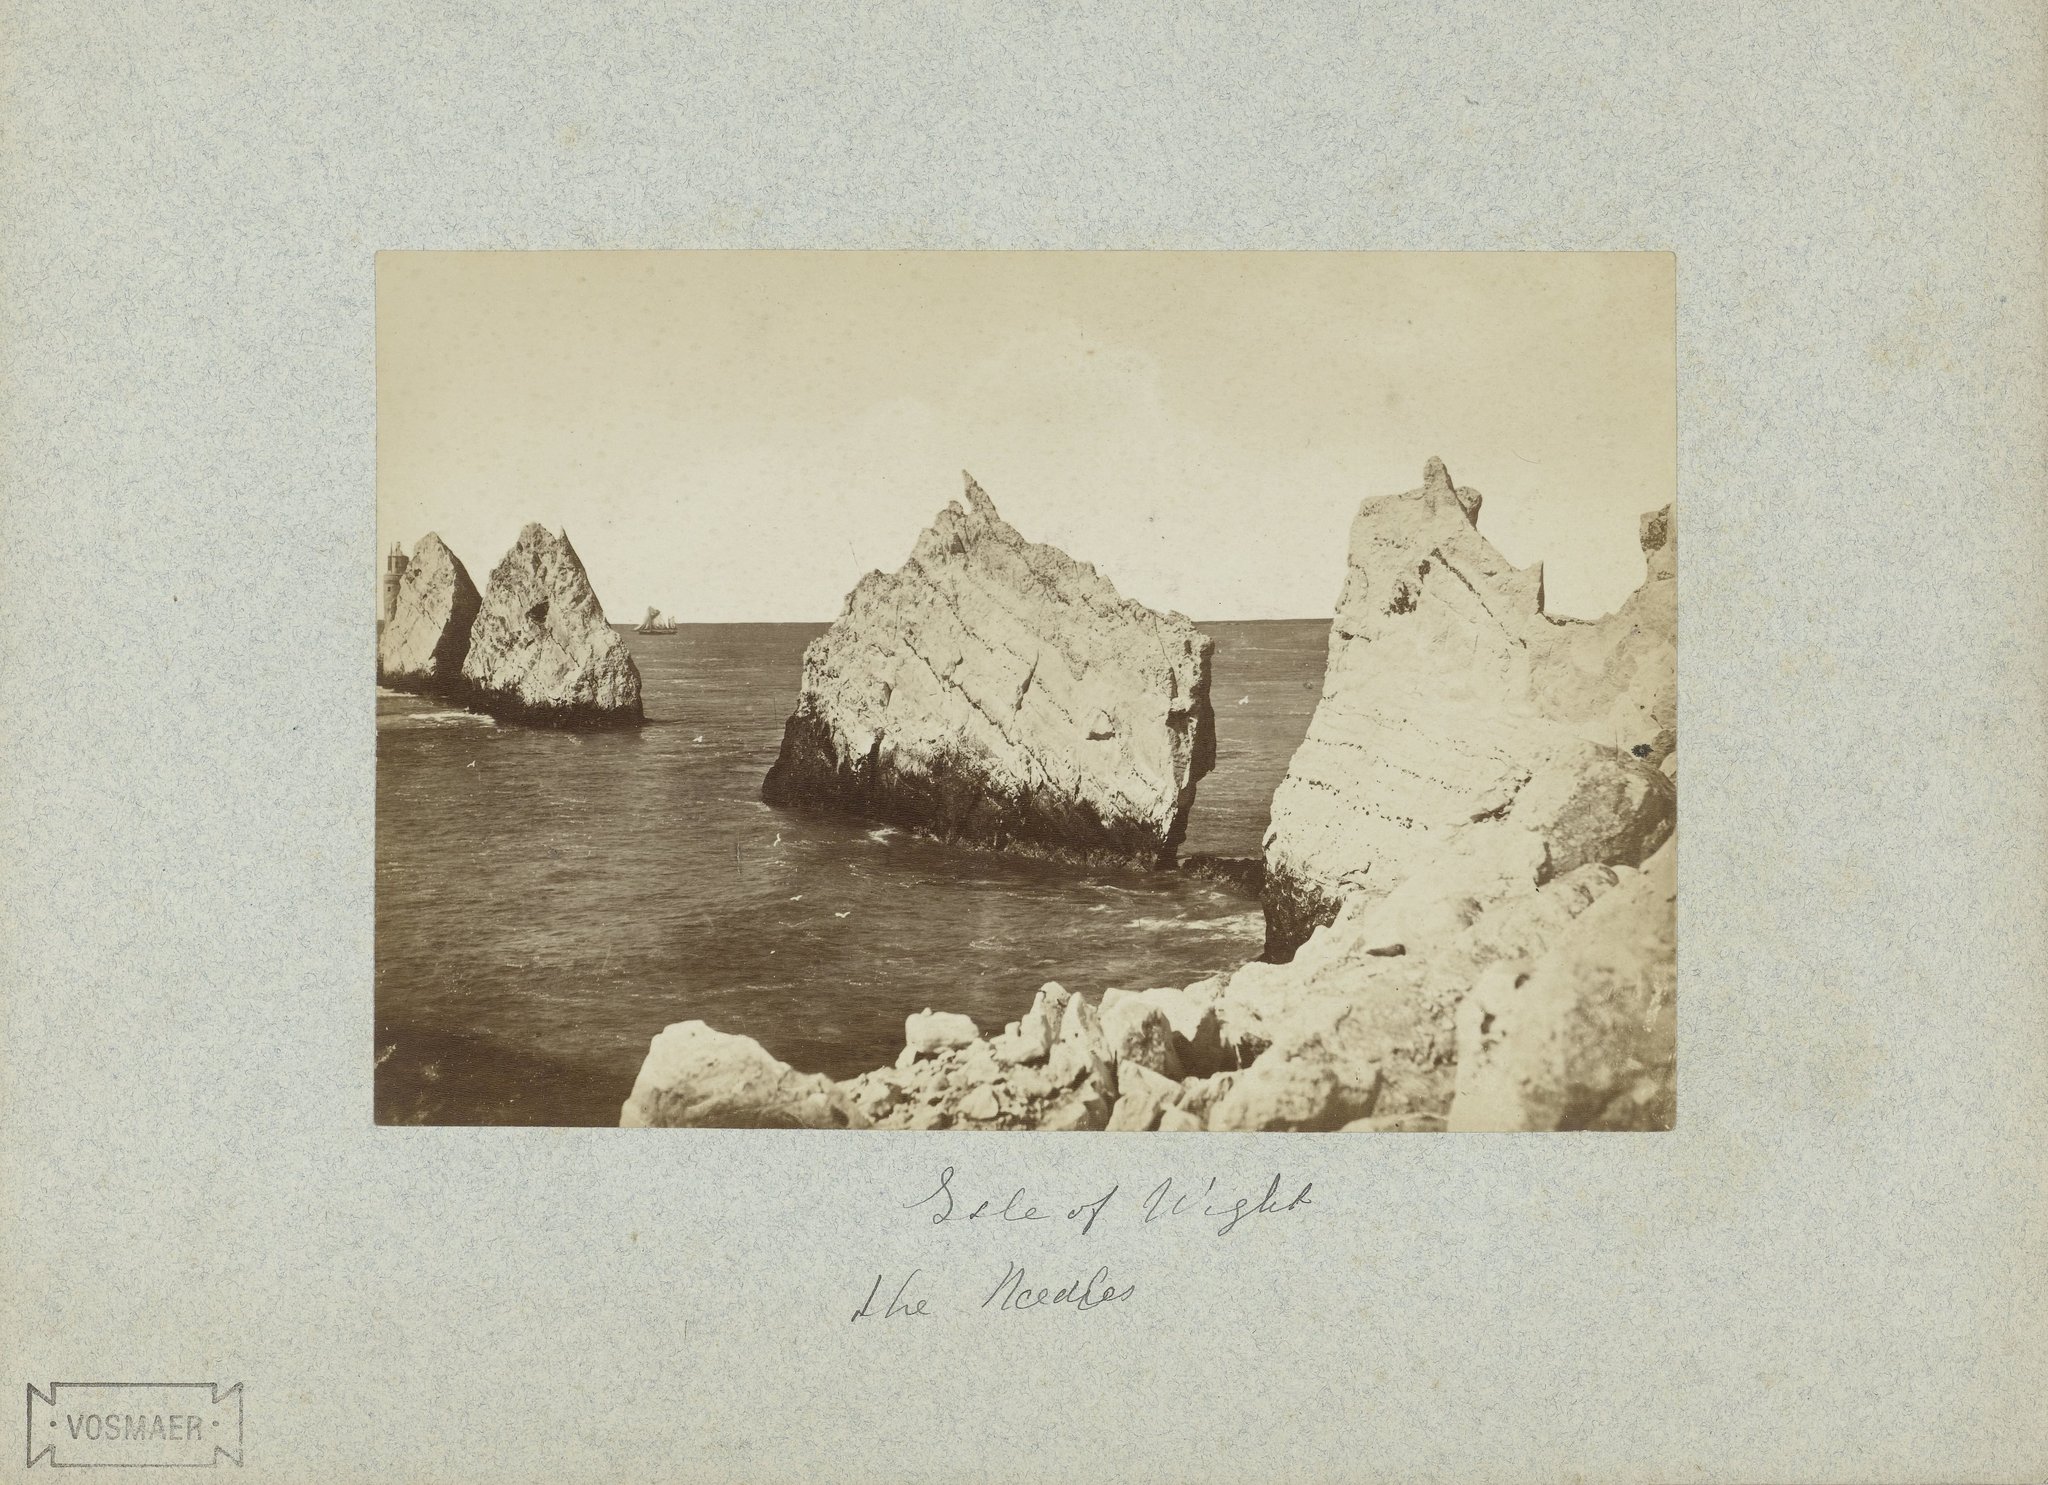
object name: photograph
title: Gezicht op The Needles, een rotsformatie voor de kust van het Isle of Wight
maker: Anonymous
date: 1851-1890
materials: cardboard, paper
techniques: albumen print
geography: isle of wight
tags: rocky coast, rock-formations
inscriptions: collector's mark: ‘VOSMAER’